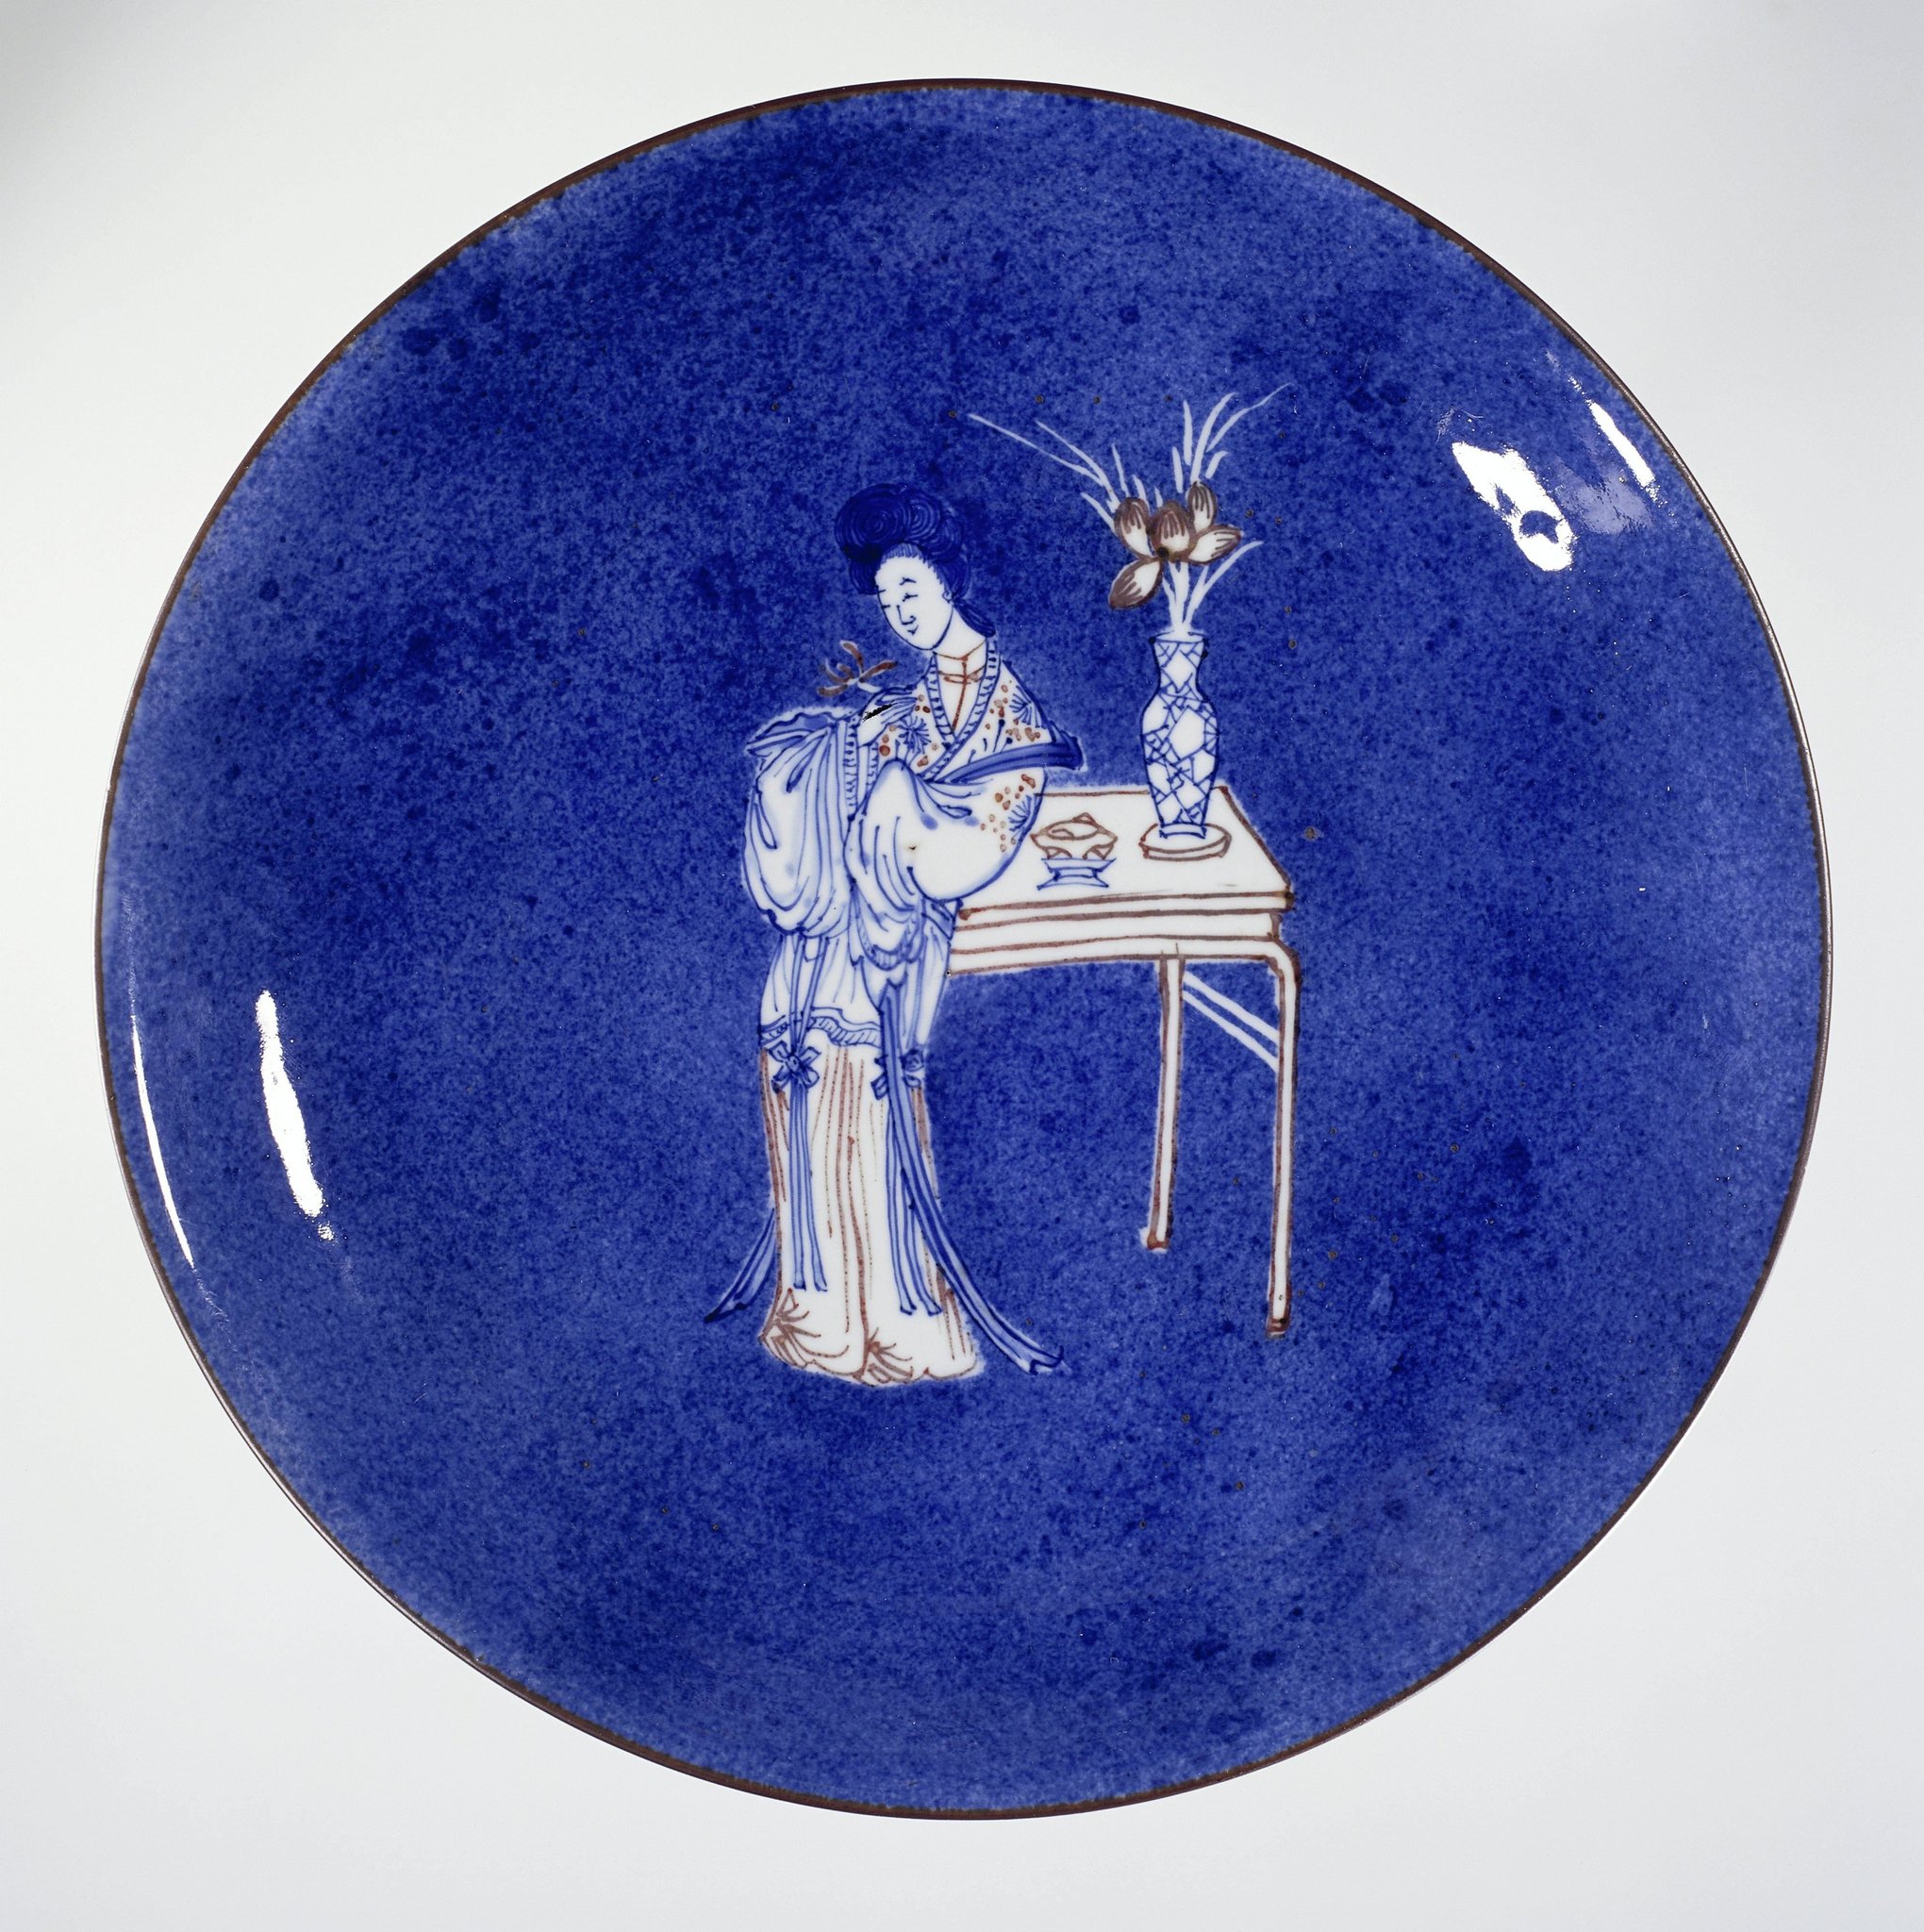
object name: dish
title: Saucer-dish with a woman on a powder blue ground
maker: Anonymous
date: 1700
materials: cobalt, copper, glaze, paint, porcelain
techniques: firing, turning, vitrification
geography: china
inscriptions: mark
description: For centuries, female figures were depicted on Chinese ceramics as part of narrative representations, which most Chinese people immediately recognized. However, in the course of the 17th century, the woman, the ‘Long Eliza,’ appears as a separate decorative element, in various poses. These objects were also made for European buyers, which may explain the use of the women as separate element; Europeans were not familiar with the Chinese stories’ context.